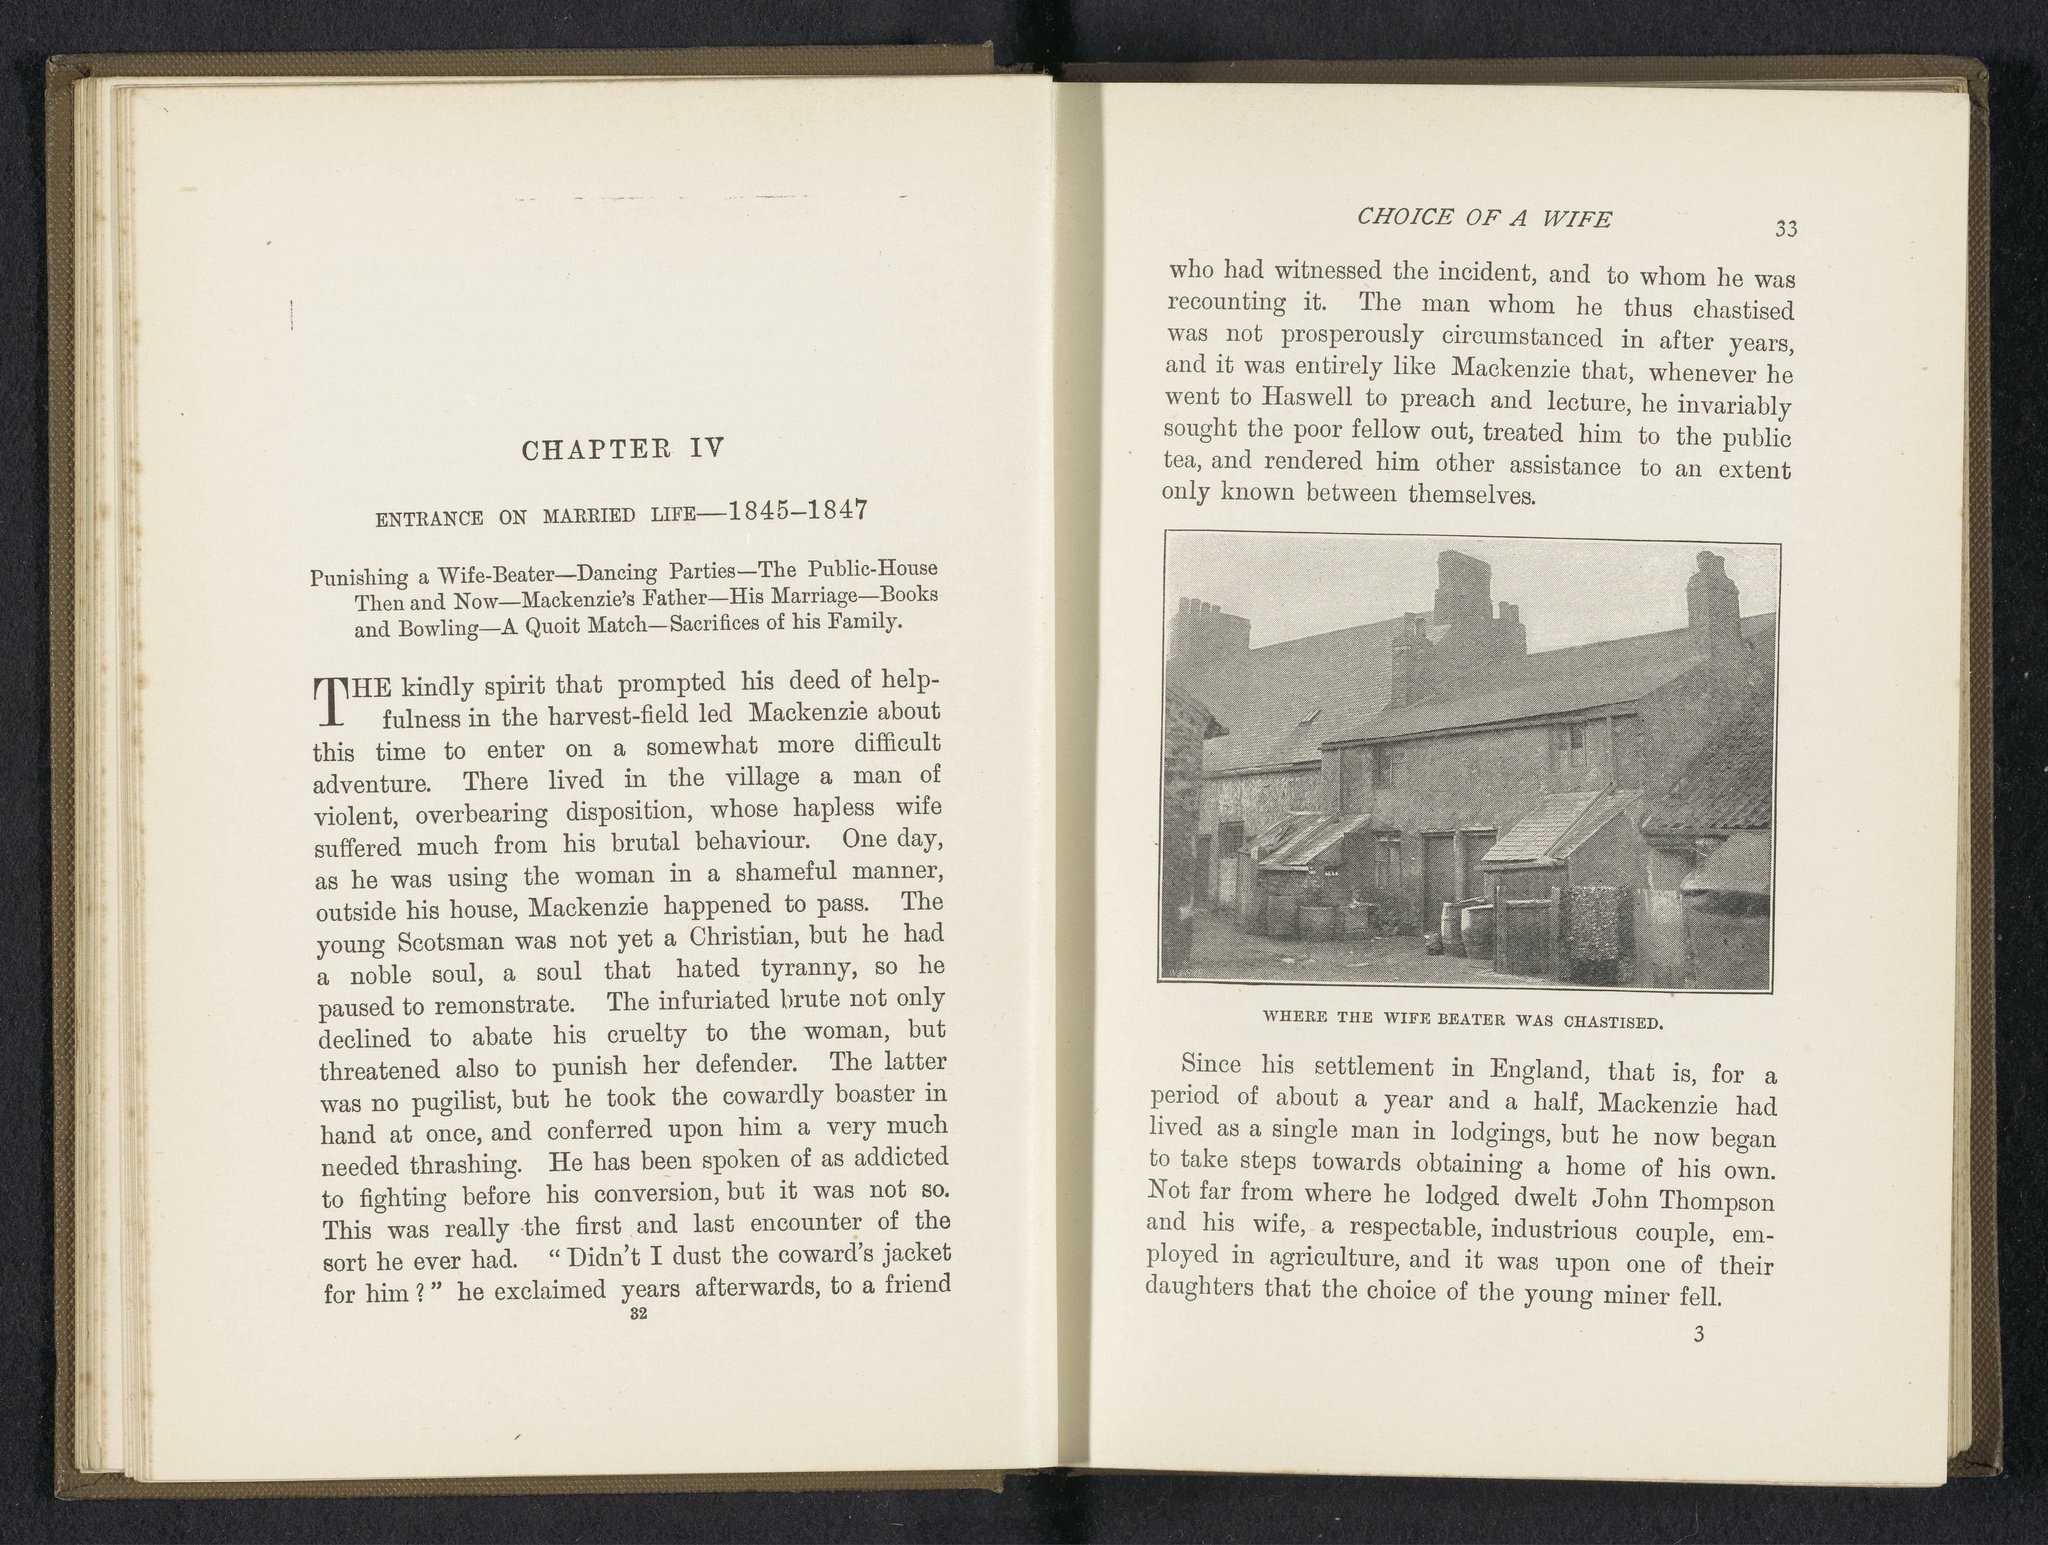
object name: photomechanical print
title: Where the wife beater was chastised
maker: Anonymous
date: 1887-1897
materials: paper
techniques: autotype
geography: haswell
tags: housing, façade (of house or building)